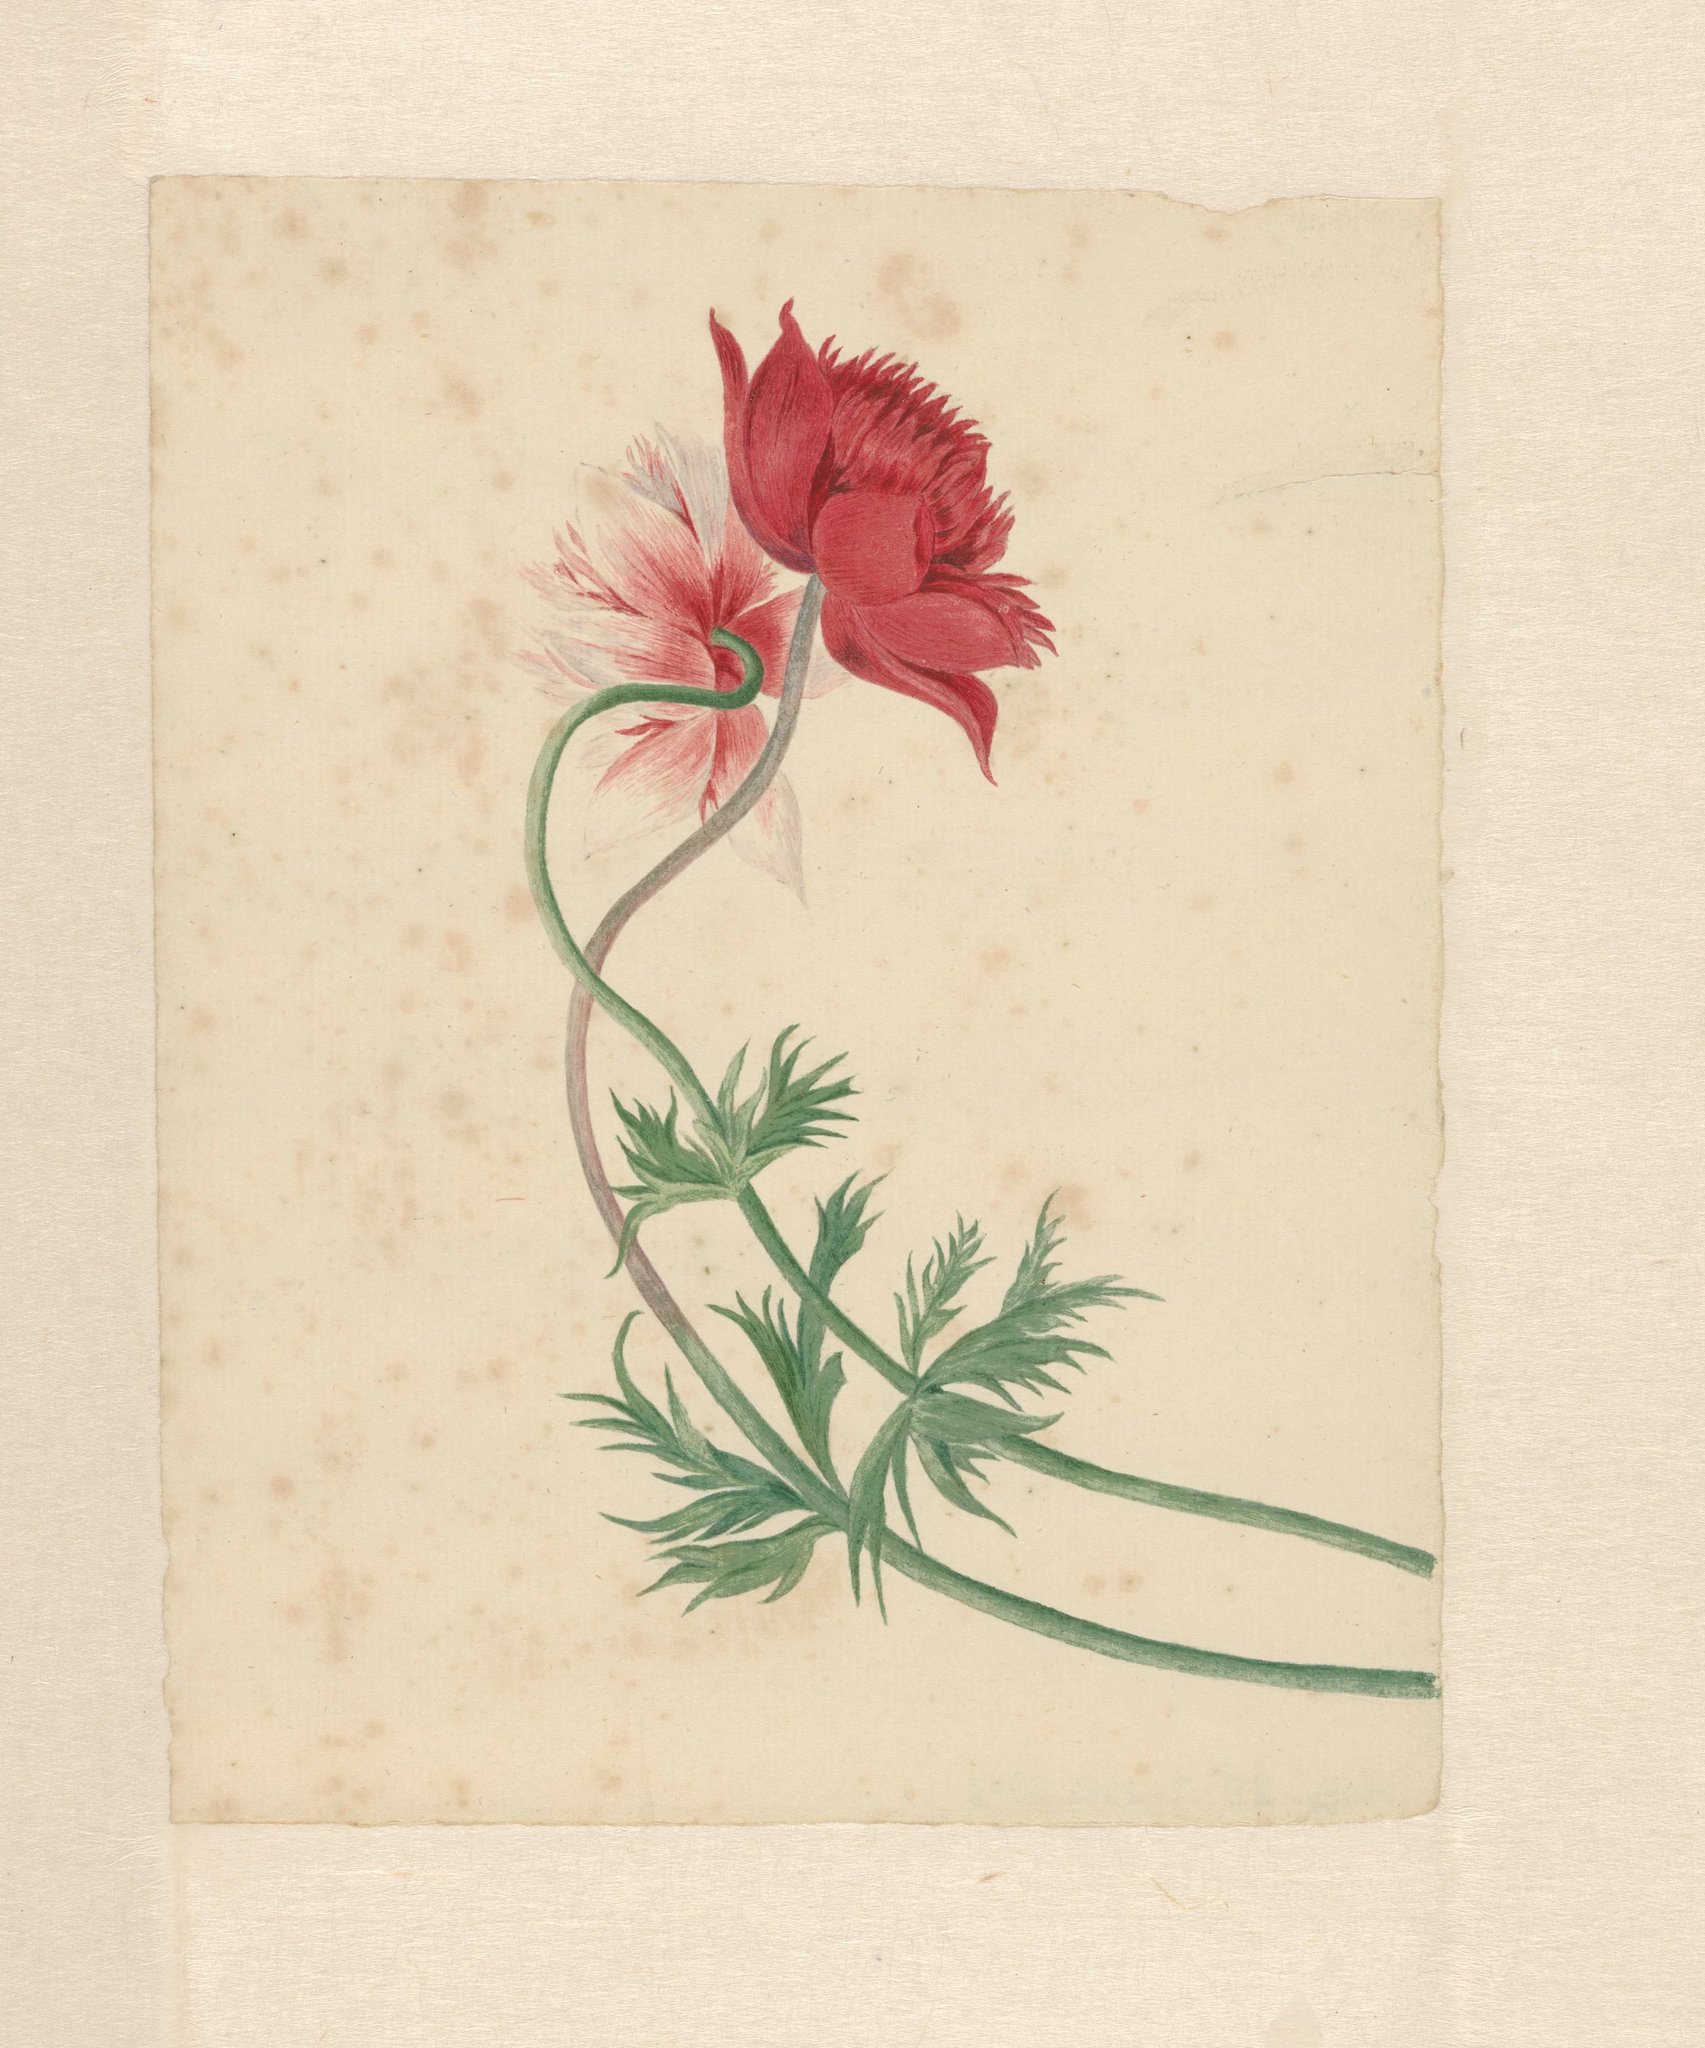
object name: drawing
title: Twee takken met elk een bloem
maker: michiel van huysum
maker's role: draughtsman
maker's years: 1704-1760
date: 1714-1760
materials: paper, pencil, watercolor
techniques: brush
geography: northern netherlands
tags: flowers: anemone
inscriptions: number: ‘13457’, number: ‘No 42’